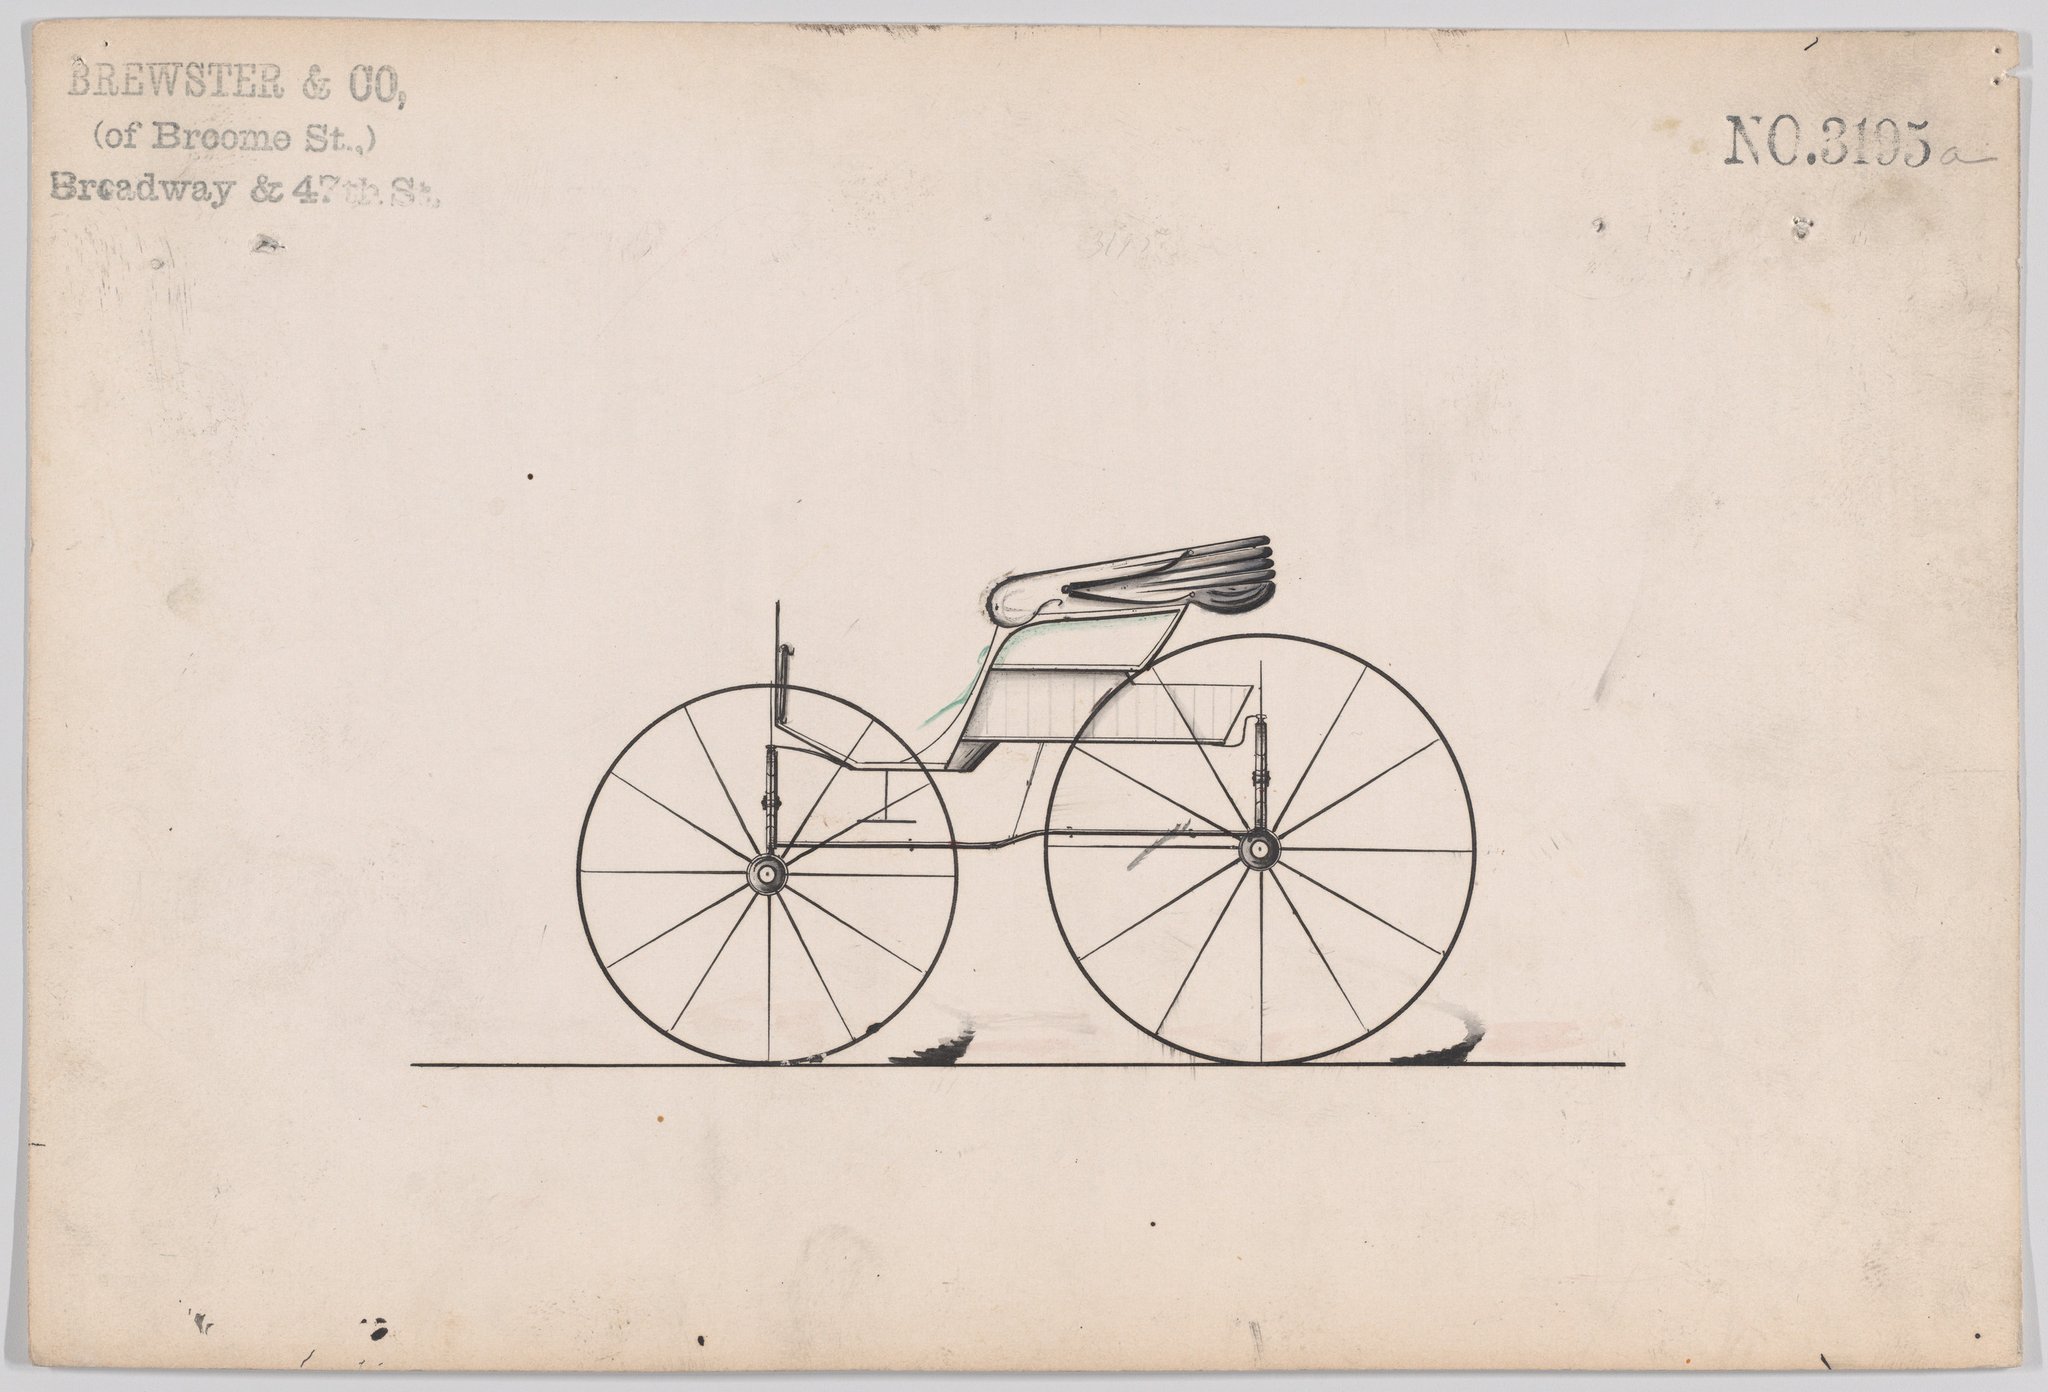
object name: drawing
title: Design for Pony Phaeton, no. 3195a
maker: brewster & co.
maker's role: manufacturer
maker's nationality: american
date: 1876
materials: gouache, ink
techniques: pen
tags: carriages